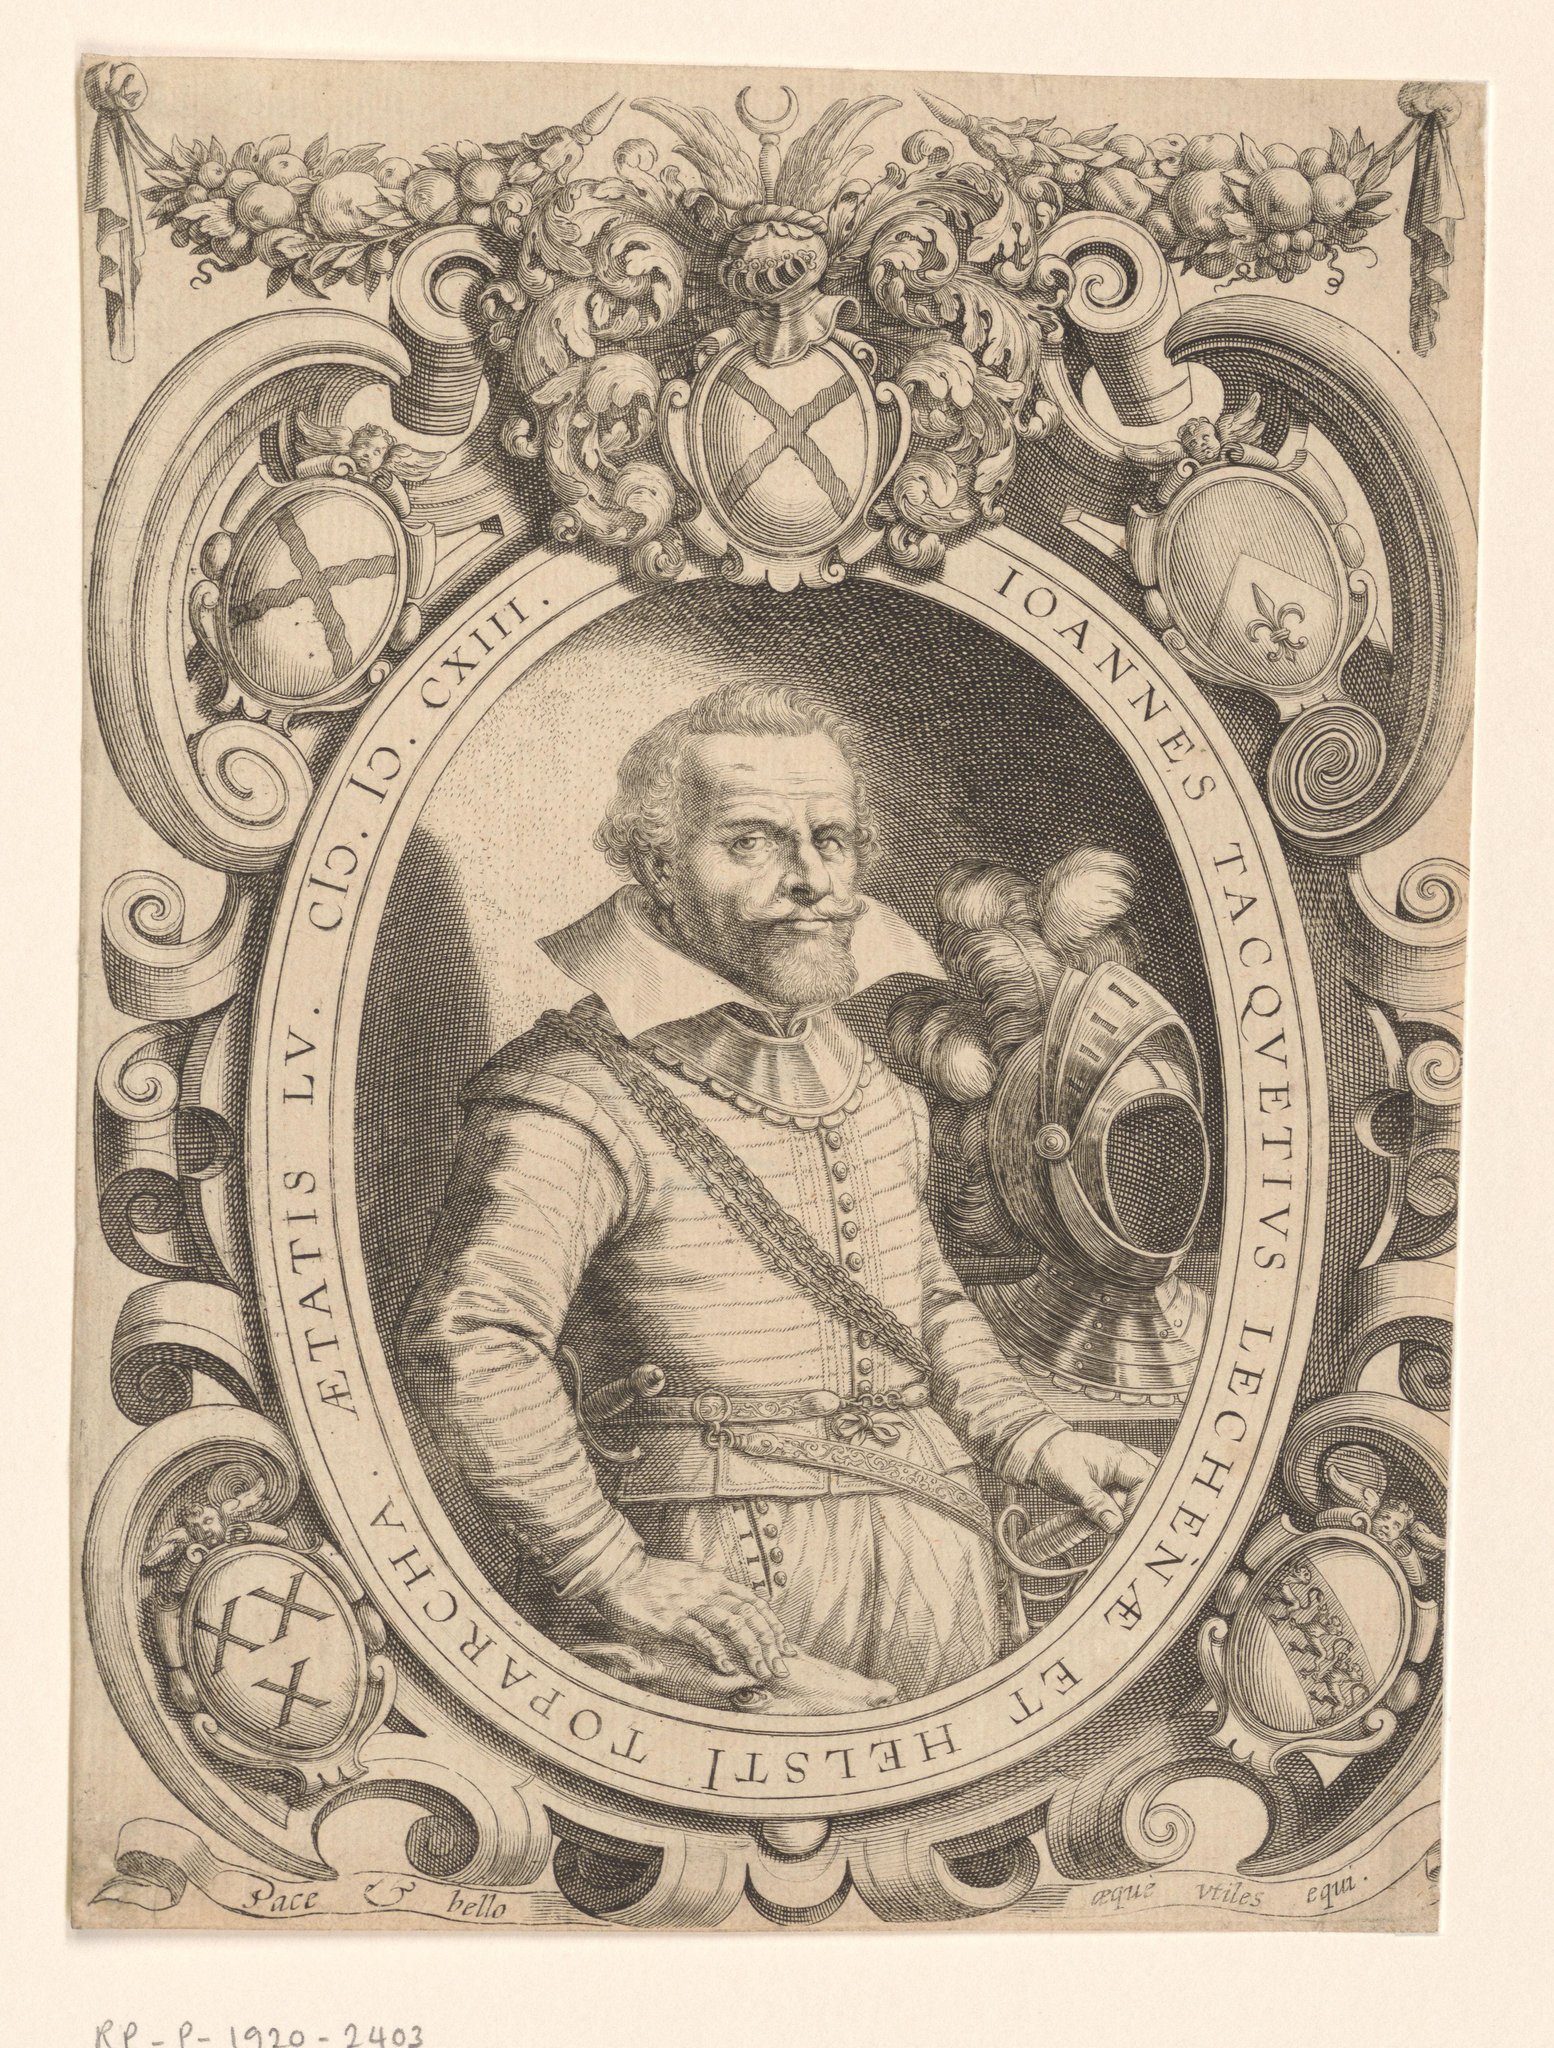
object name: print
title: Portret van Johannes Tacquet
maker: Anonymous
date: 1614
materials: paper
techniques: engraving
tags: antwerp, bruges, helmet, historical persons, portrait of a writer, armorial bearing, heraldry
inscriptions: collector's mark: Lugt 2228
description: Prent gebruikt in: Tacquet, Johannes. Philippica, ou haras de chevaux. Antwerpen: Robert Bruneau, 1614.